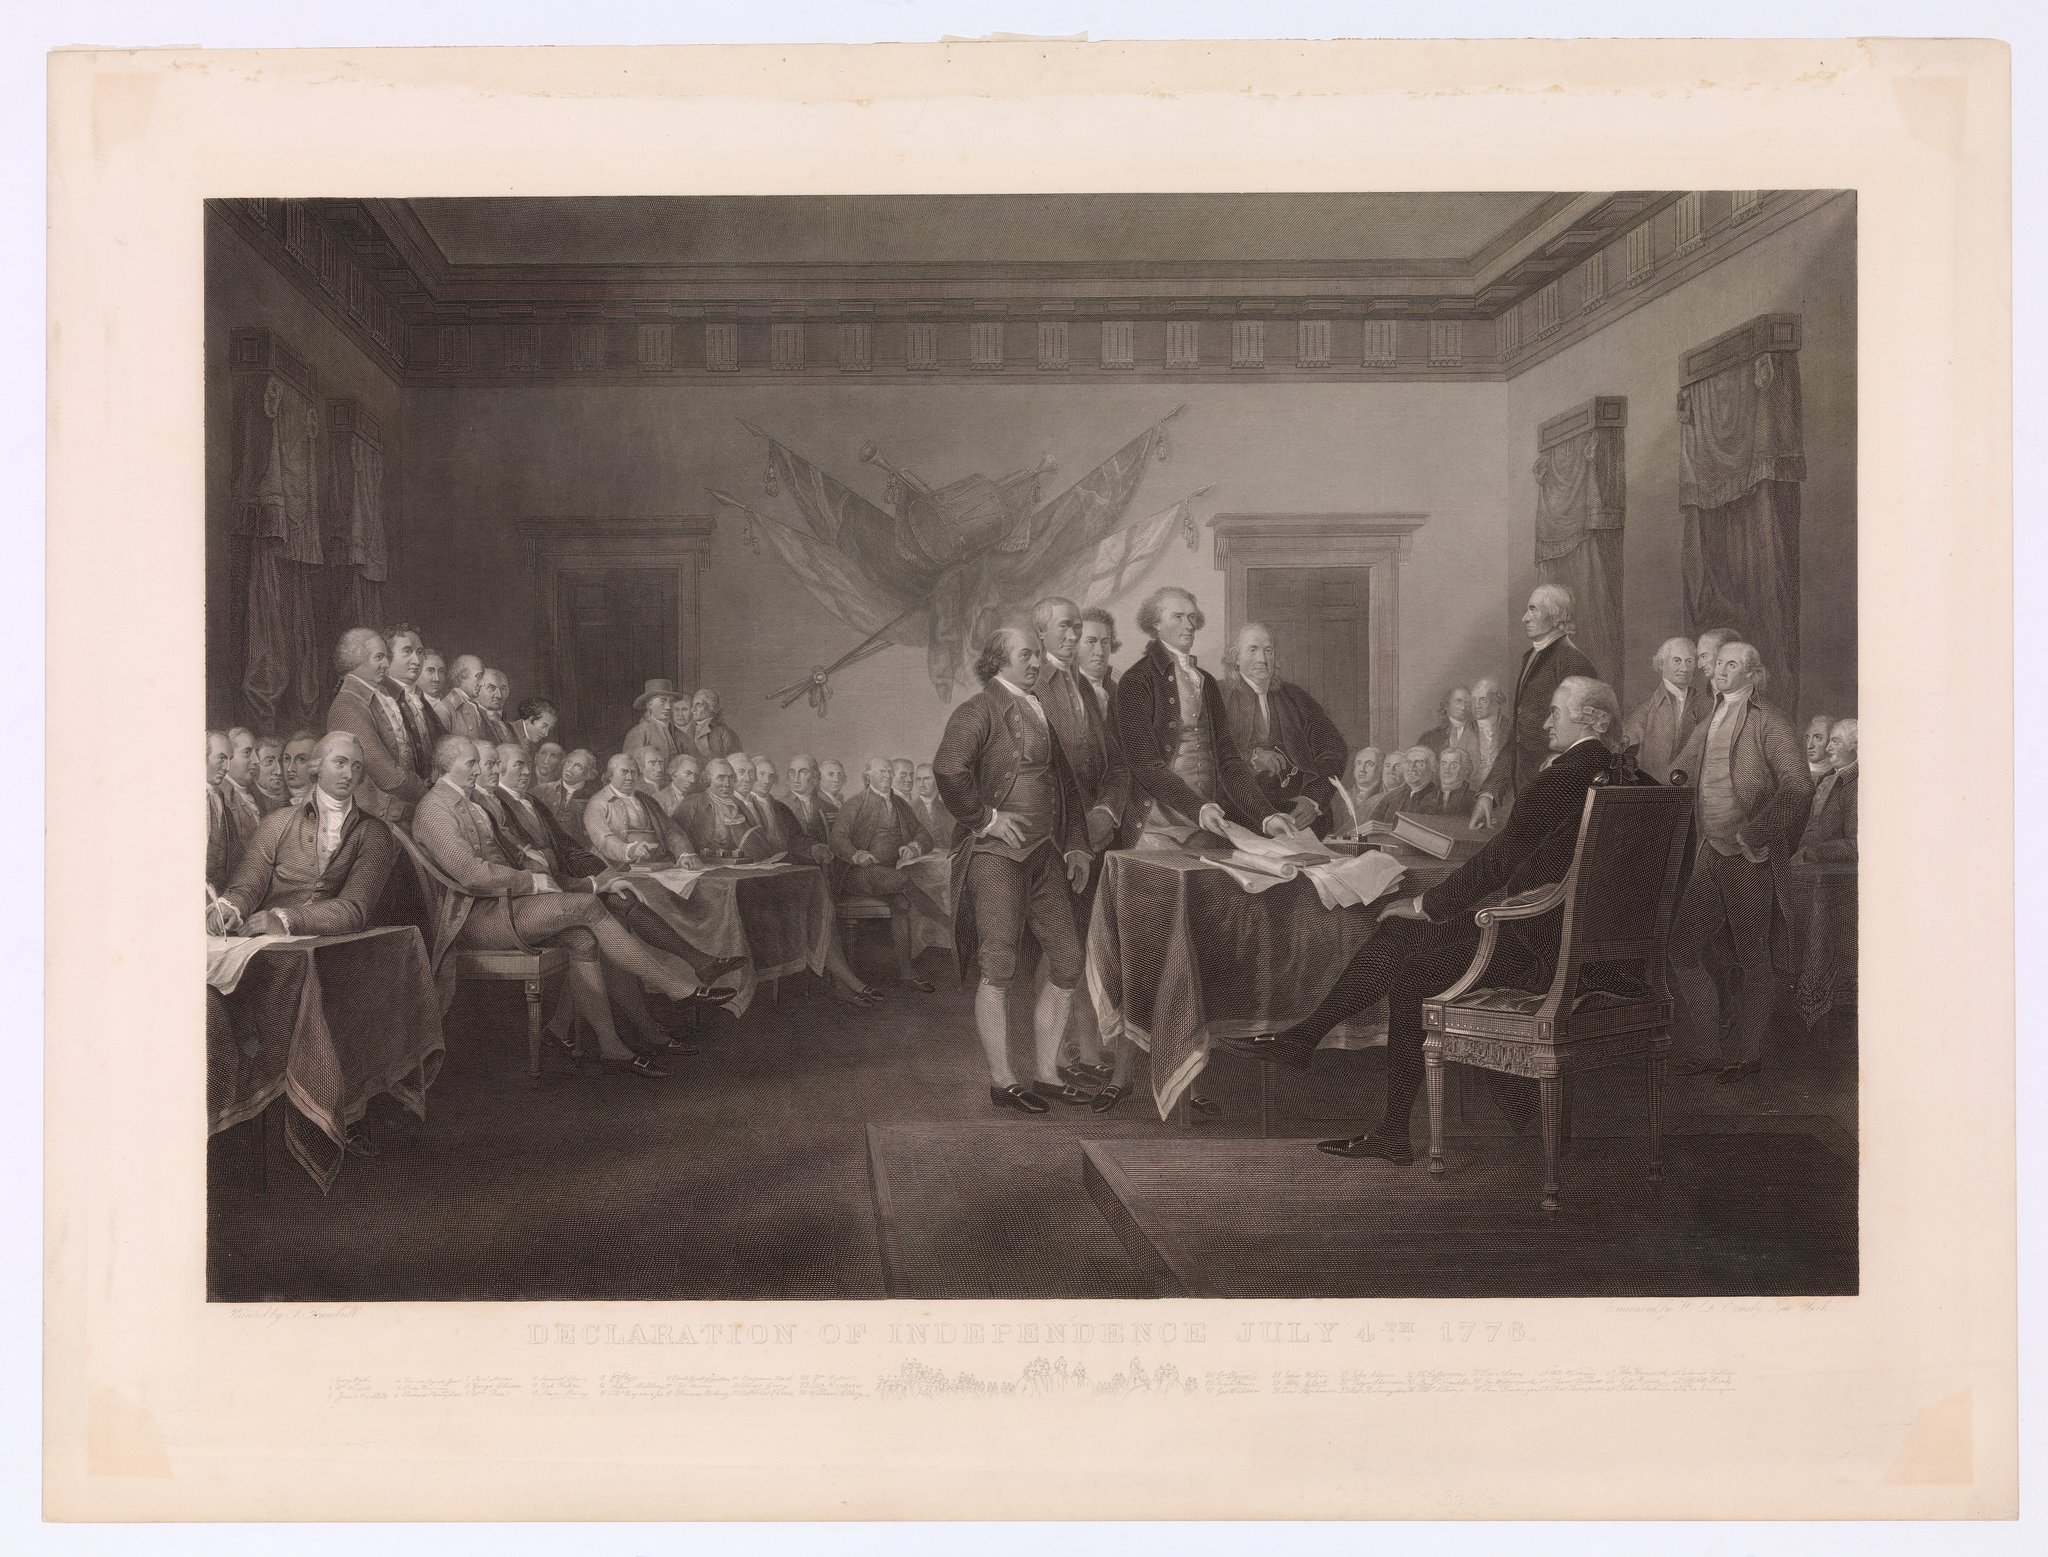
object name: print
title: The Declaration of Independence, July 4, 1776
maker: waterman lilly ormsby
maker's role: engraver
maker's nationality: american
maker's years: 1809-1883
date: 1876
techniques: engraving